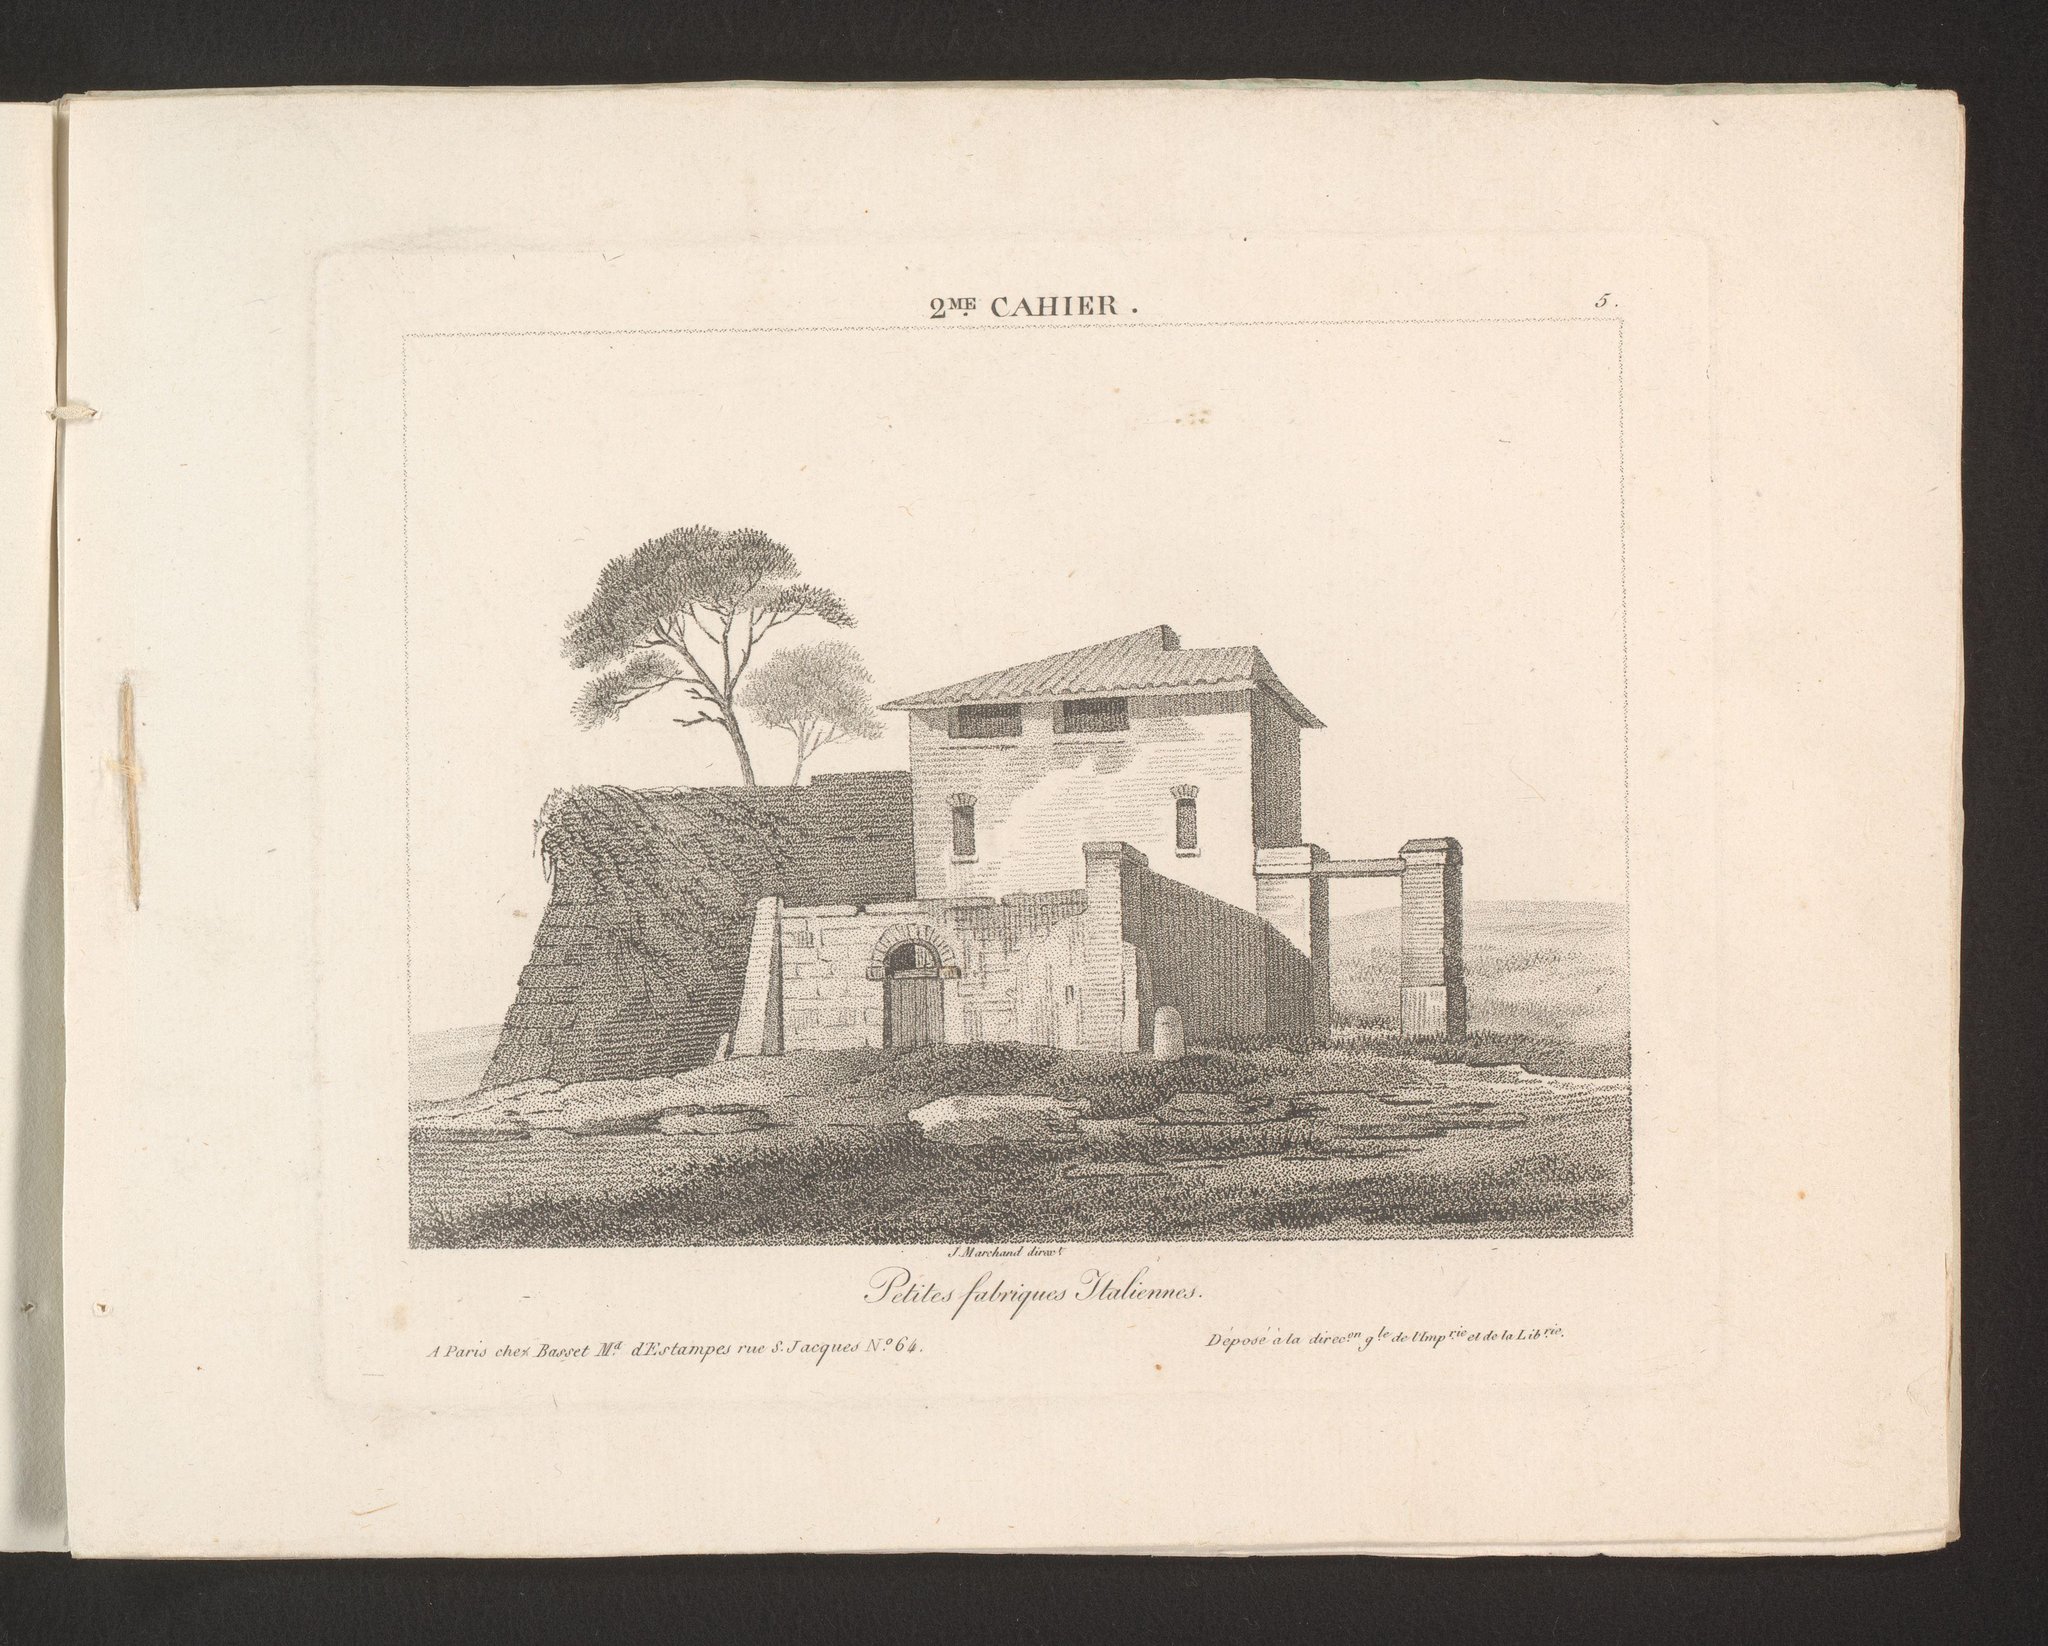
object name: album leaf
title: Titelprent voor een serie tekenvoorbeelden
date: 1800-1825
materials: paper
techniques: printmaking, engraving, etching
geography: paris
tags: factory in landscape, rural housing, e.g. country-house, villa, cottage, italy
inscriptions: collector's mark: Lugt 2760, collector's mark: Lugt 2228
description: Vrijstaand gebouw met ommuurd erf. Deze prent maakt deel uit van een album.